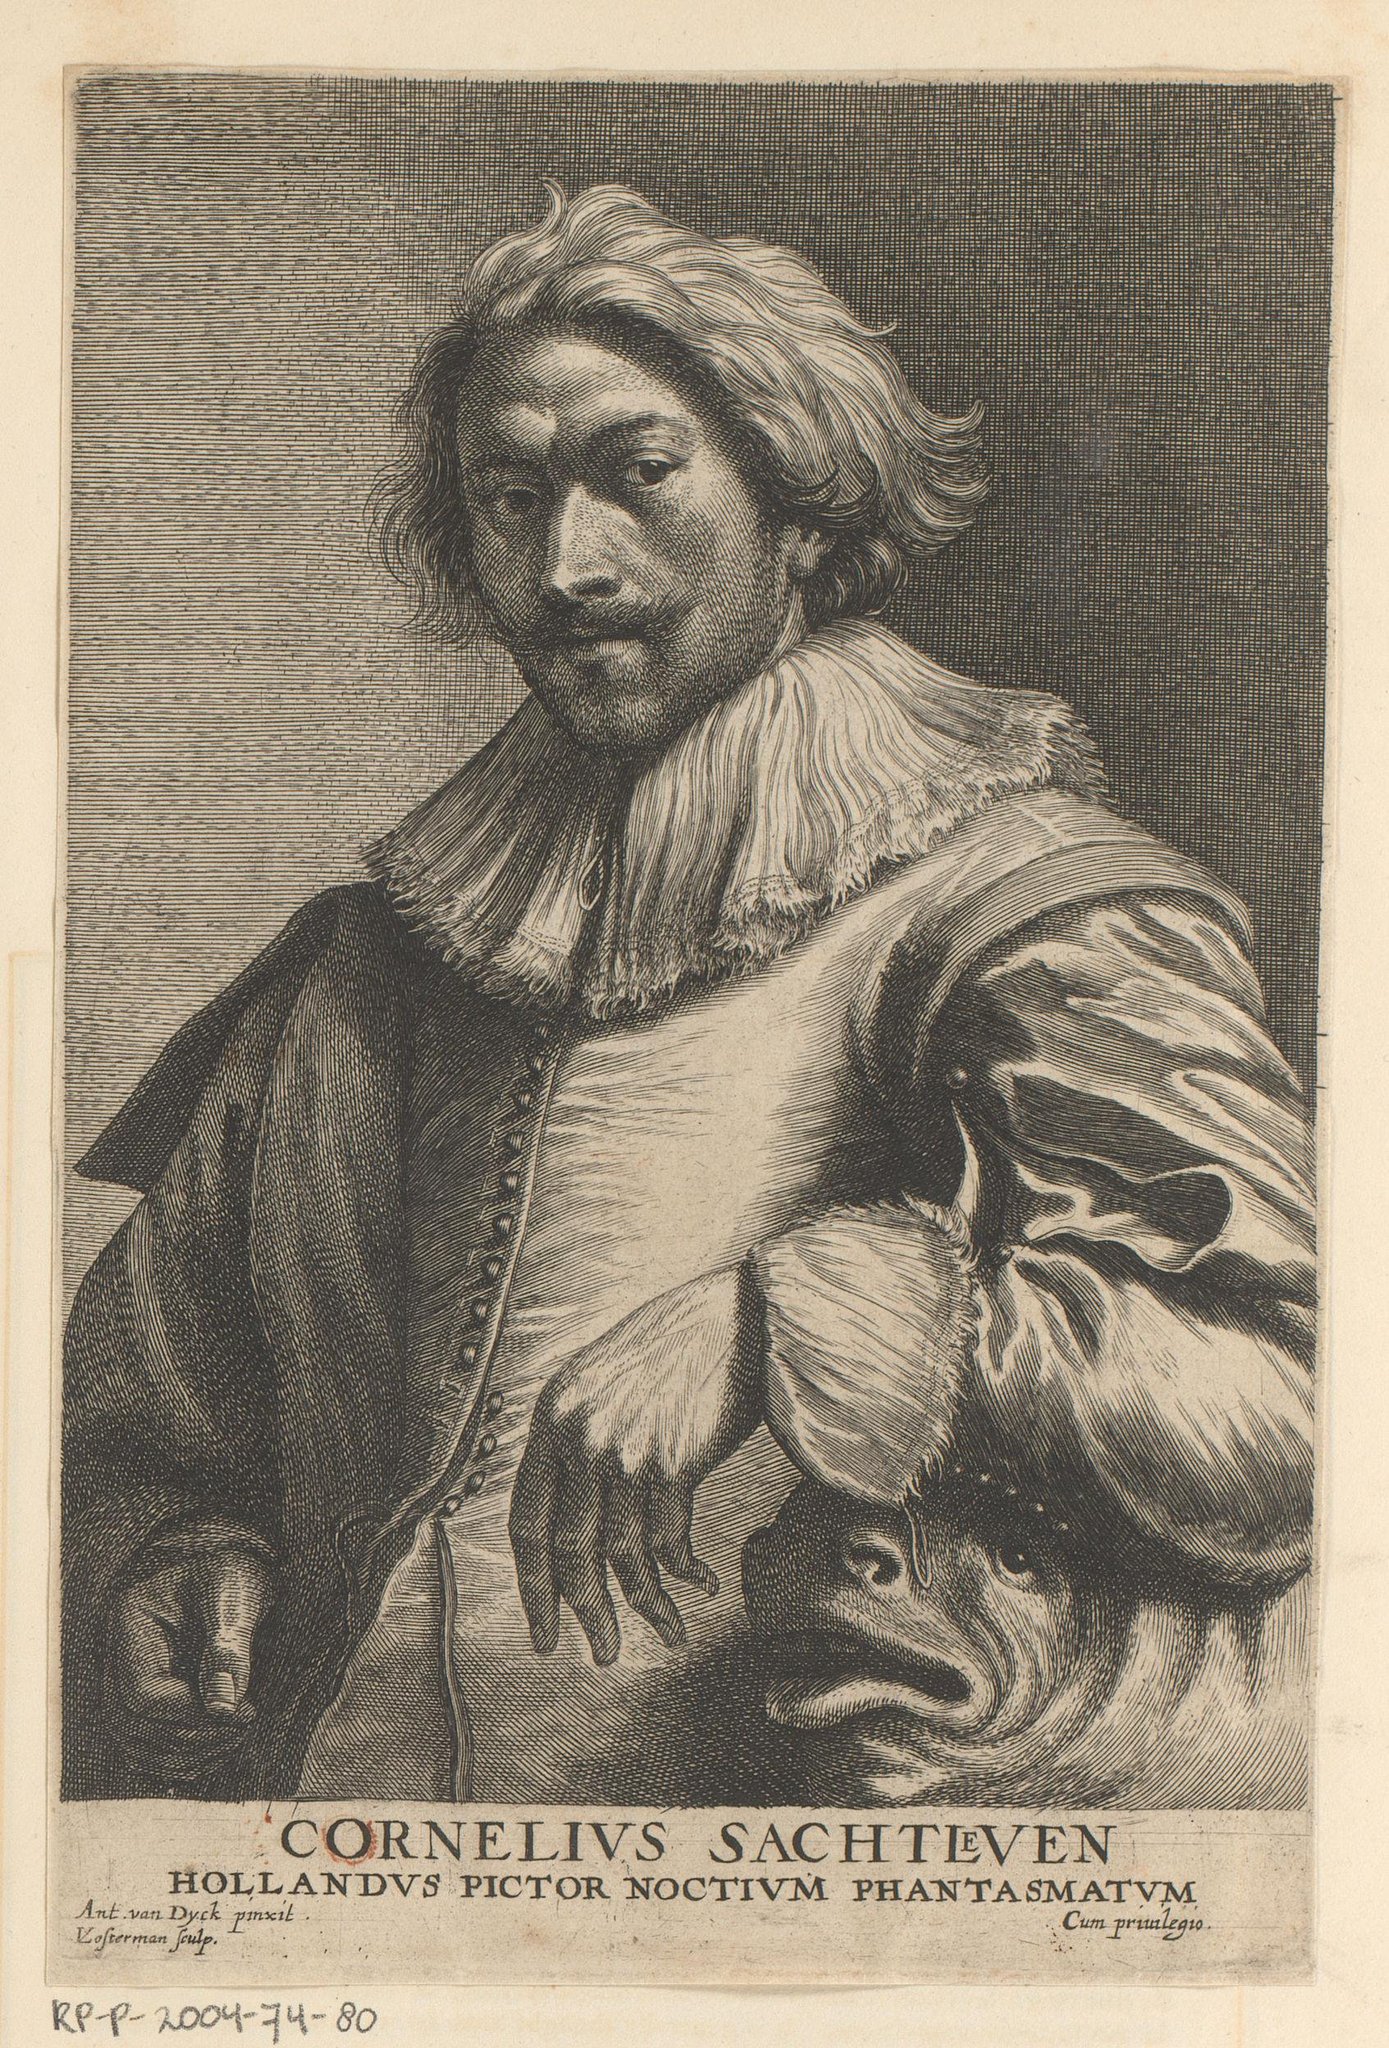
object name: album leaf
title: Portret van Cornelis Saftleven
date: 1645-1646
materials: paper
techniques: engraving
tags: rotterdam, painter, print maker, draughtsman, cornelis saftleven, historical persons, portrait, self-portrait of painter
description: Prent mogelijk uit: Iconographie ou Vies des Hommes Illustres du XVII. Siecle (...). 2 dln. Amsterdam: Johann Caspar Arkstee, Leipzig: Henricus Merkus, 1759. Prent is ontworpen voor de serie getiteld 'Iconographie' samengesteld door Anthony van Dyck en uitgegeven in 1645-1646. De samensteller heeft deze prent in het album geplakt als illustratie bij: Pilkington, Matthew en Johann Heinrich Füssli. A dictionary of painters, from the revival of the art to the present period. 4 dln. Londen: John Crowder, 1805, dl. 3, p. 488.